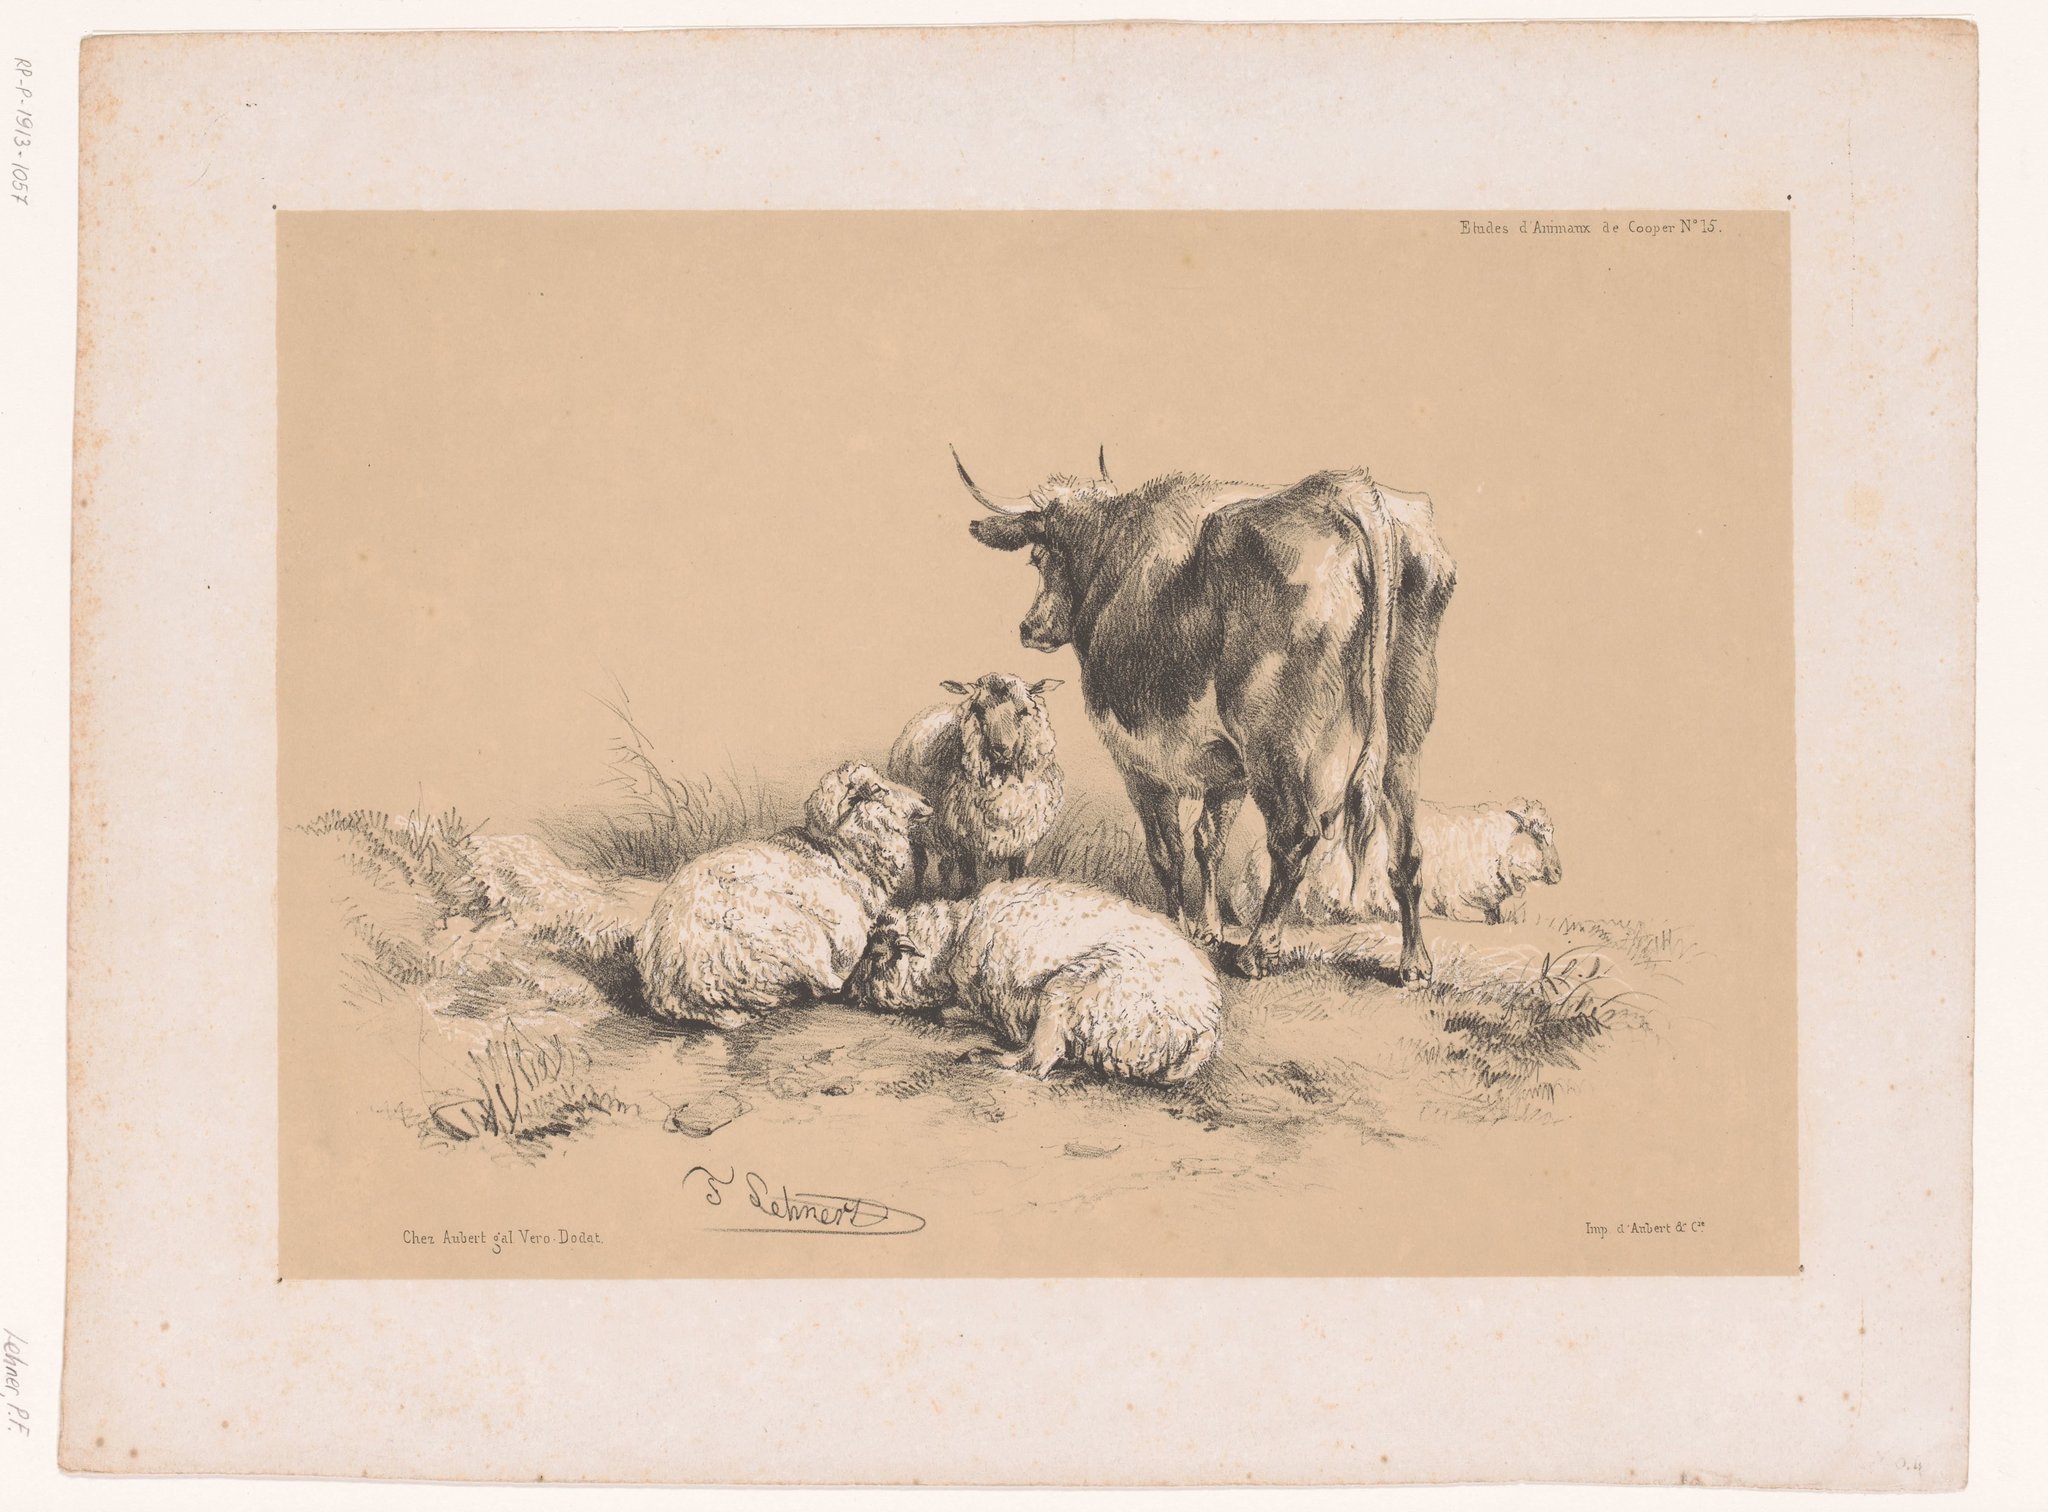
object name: print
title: Studies van vier schapen en een koe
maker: pierre frédéric lehnert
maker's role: print maker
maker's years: 1811-1880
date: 1838-1840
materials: paper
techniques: tone lithography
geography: paris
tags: cow, sheep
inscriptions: collector's mark: Lugt 2228a